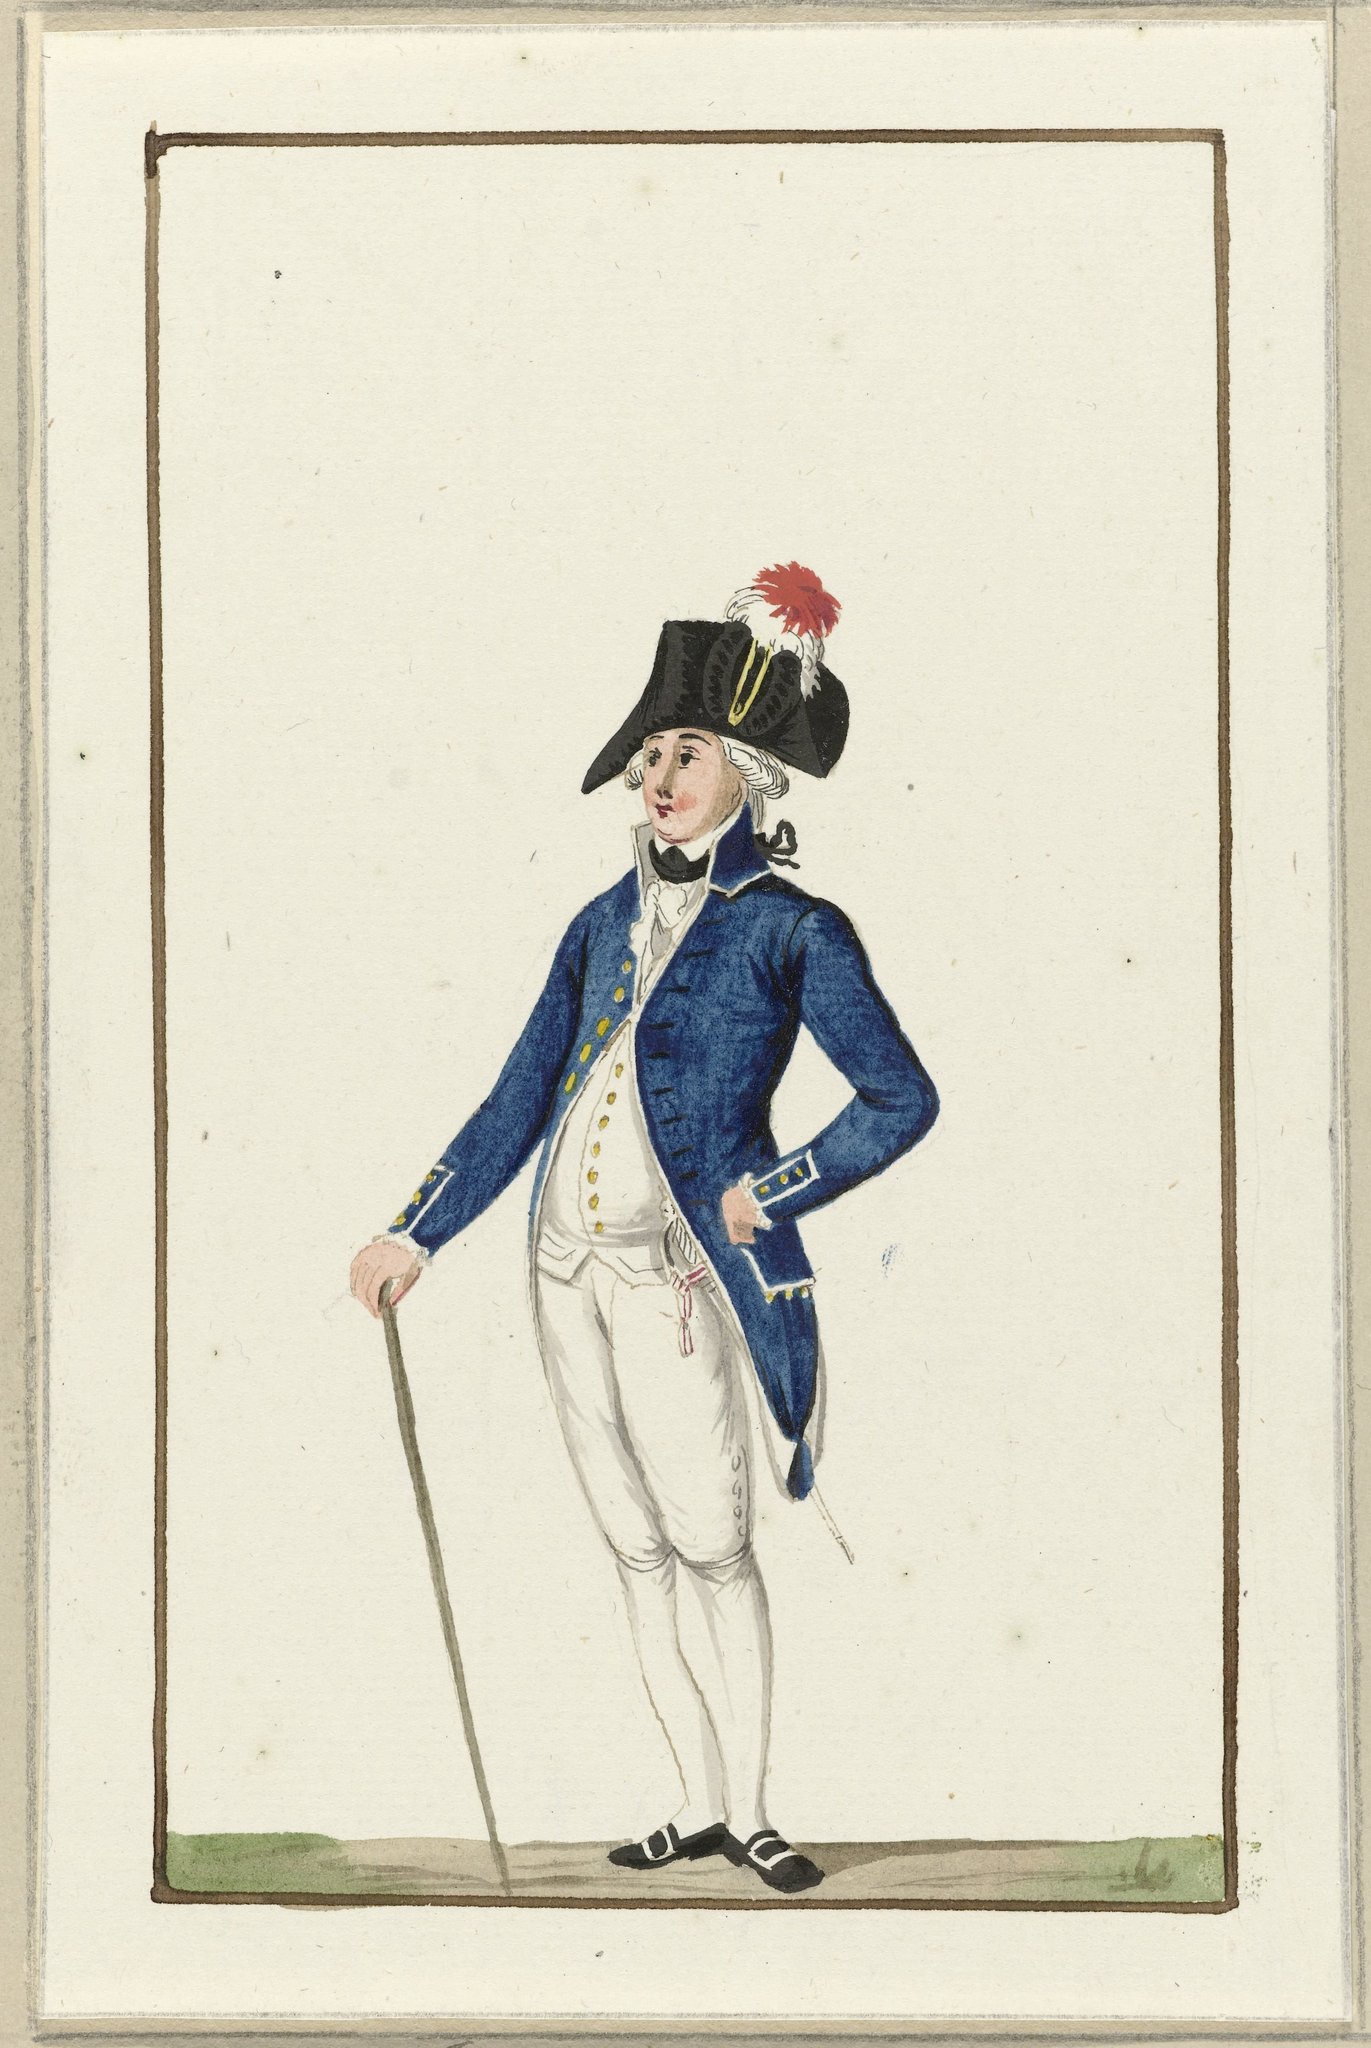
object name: drawing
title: Montering van het Goudse exercitiegenootschap, ca. 1787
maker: Anonymous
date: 1787-1790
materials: paper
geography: northern netherlands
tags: (military) uniforms (+ citizen soldiery, civil guard, citizen militia), gouda, patriots (1780-1795)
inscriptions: collector's mark: Lugt 2228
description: Uniform van het exercitiegenootschap van Gouda. Onderdeel van een serie van 32 tekeningen van de verschillende monteringen (uniformen) van patriotse schutterijen en burgerkorpsen in Nederland in 1787.